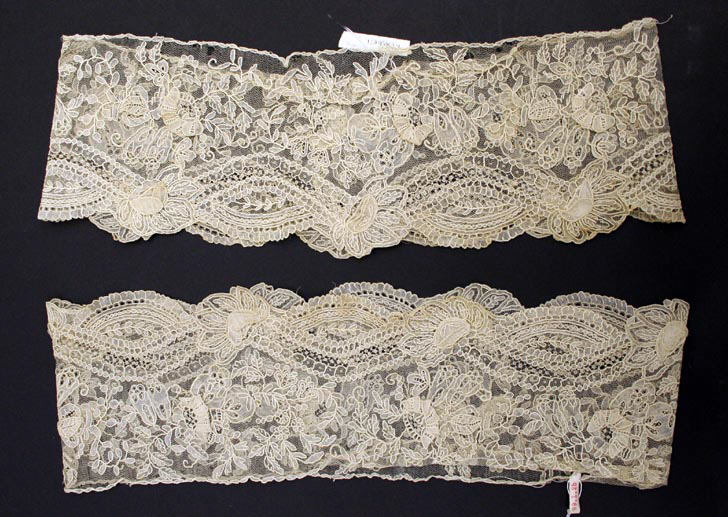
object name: cuff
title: Cuffs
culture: belgian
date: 1801-1825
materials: linen